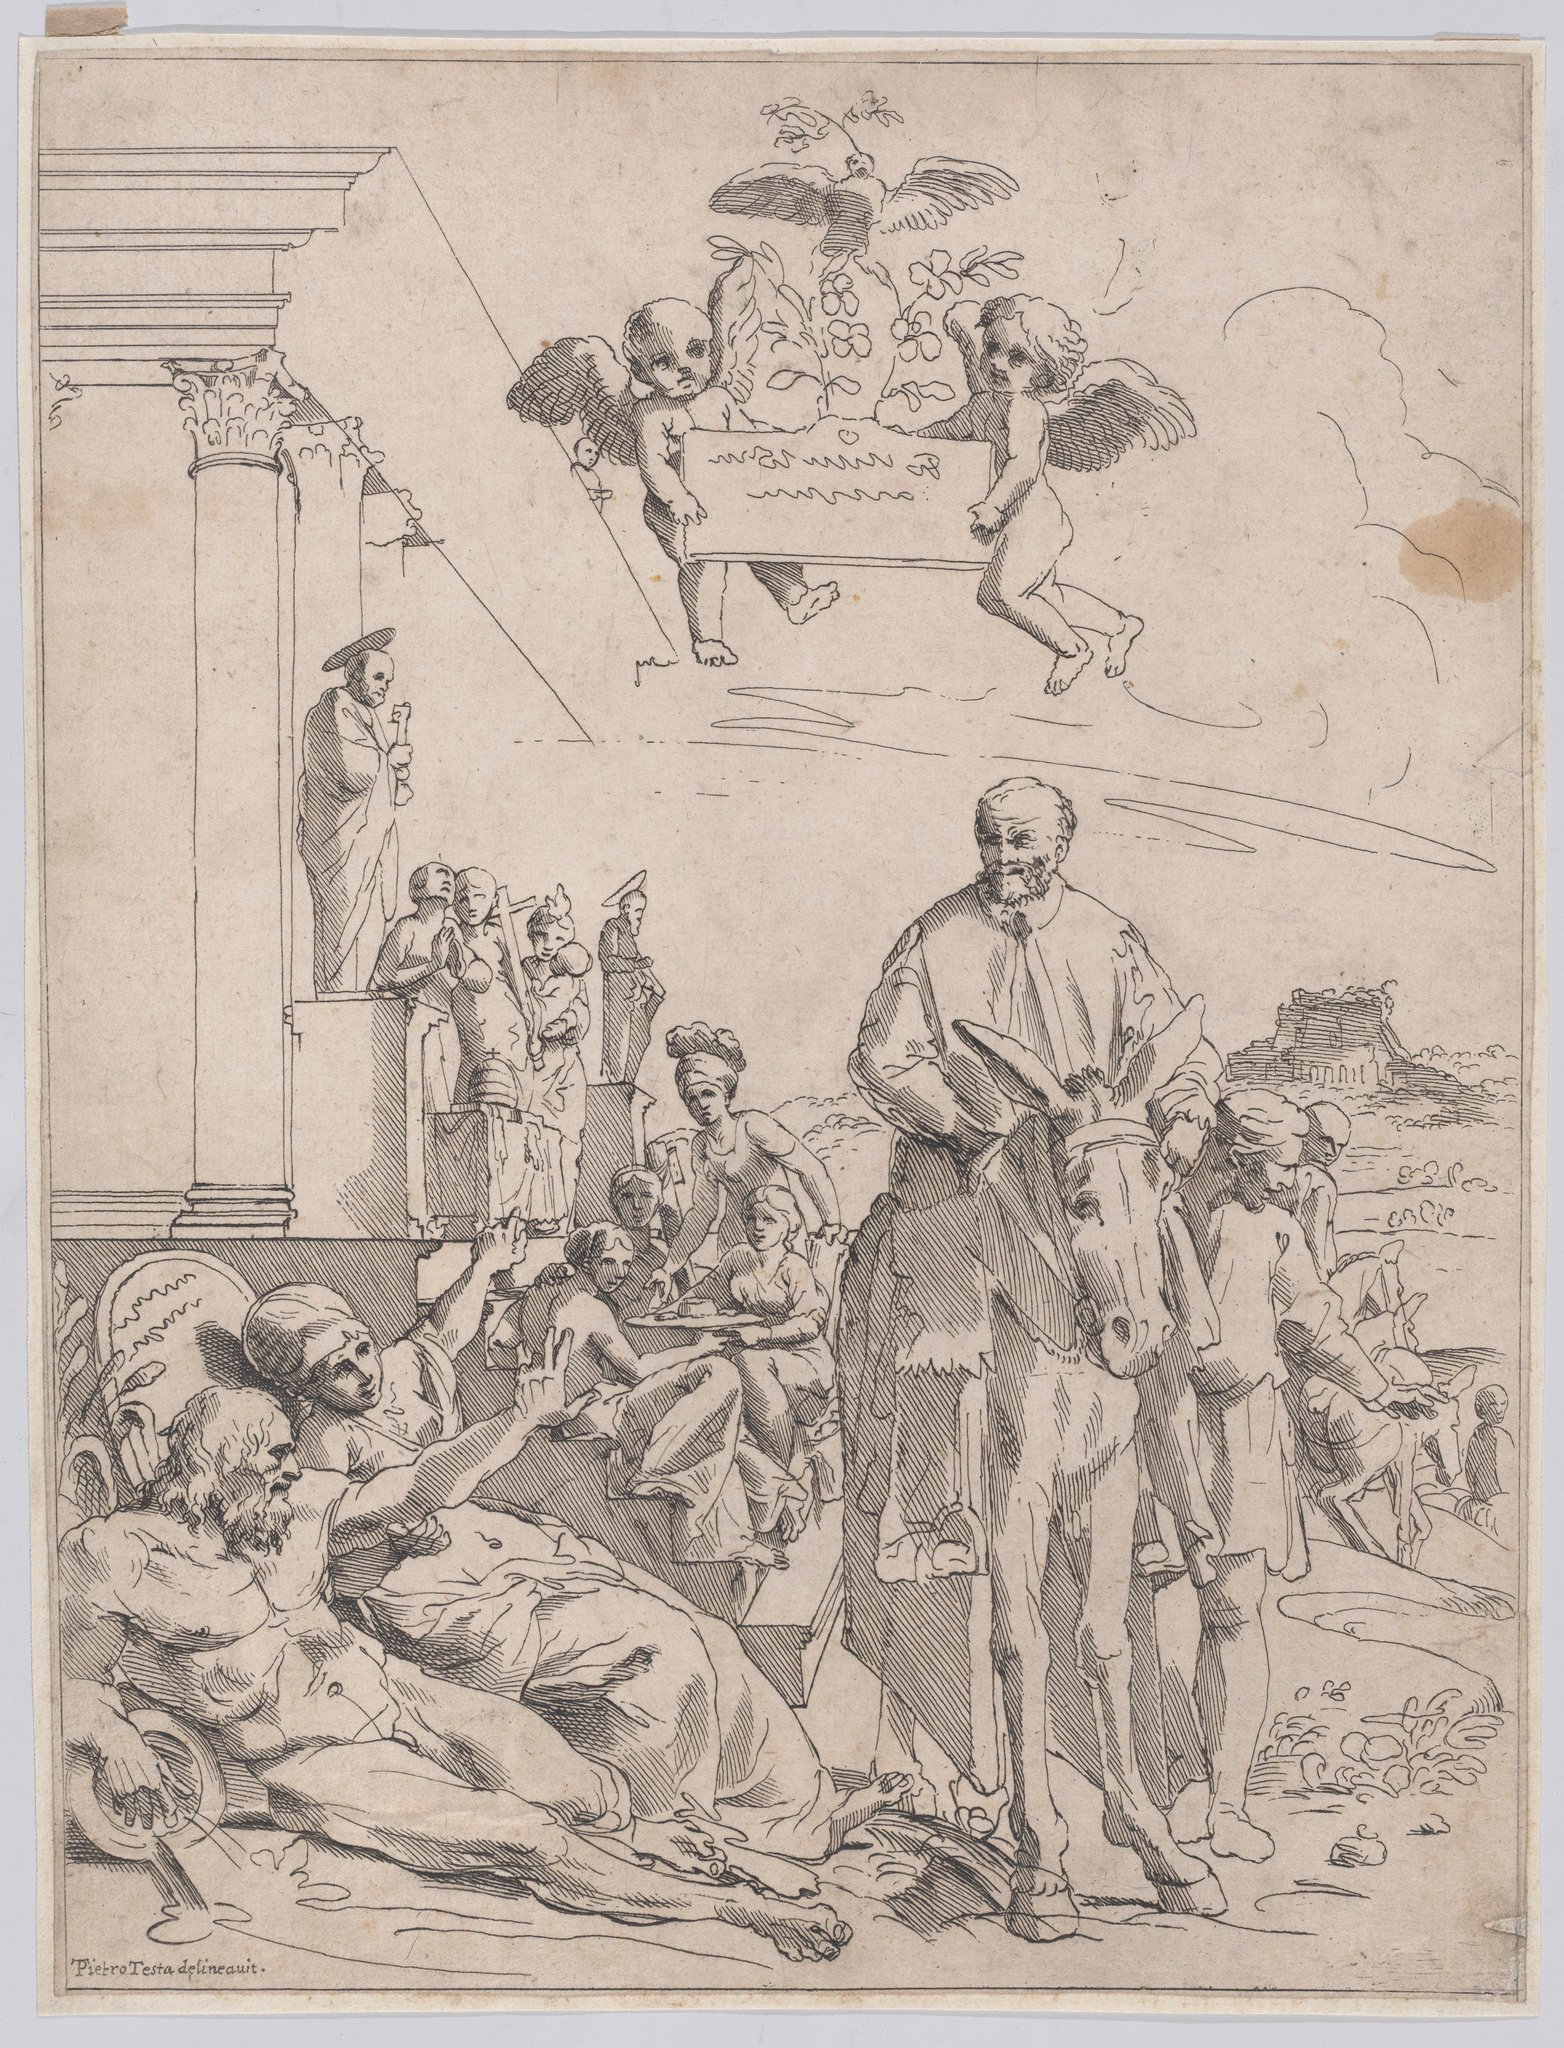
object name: print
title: An allegory with Innocent X who is seated on horsback on the right, figures represting Rome in the lowe left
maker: françois collignon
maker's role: artist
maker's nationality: french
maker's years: 1605-1687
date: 1645-1655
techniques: etching